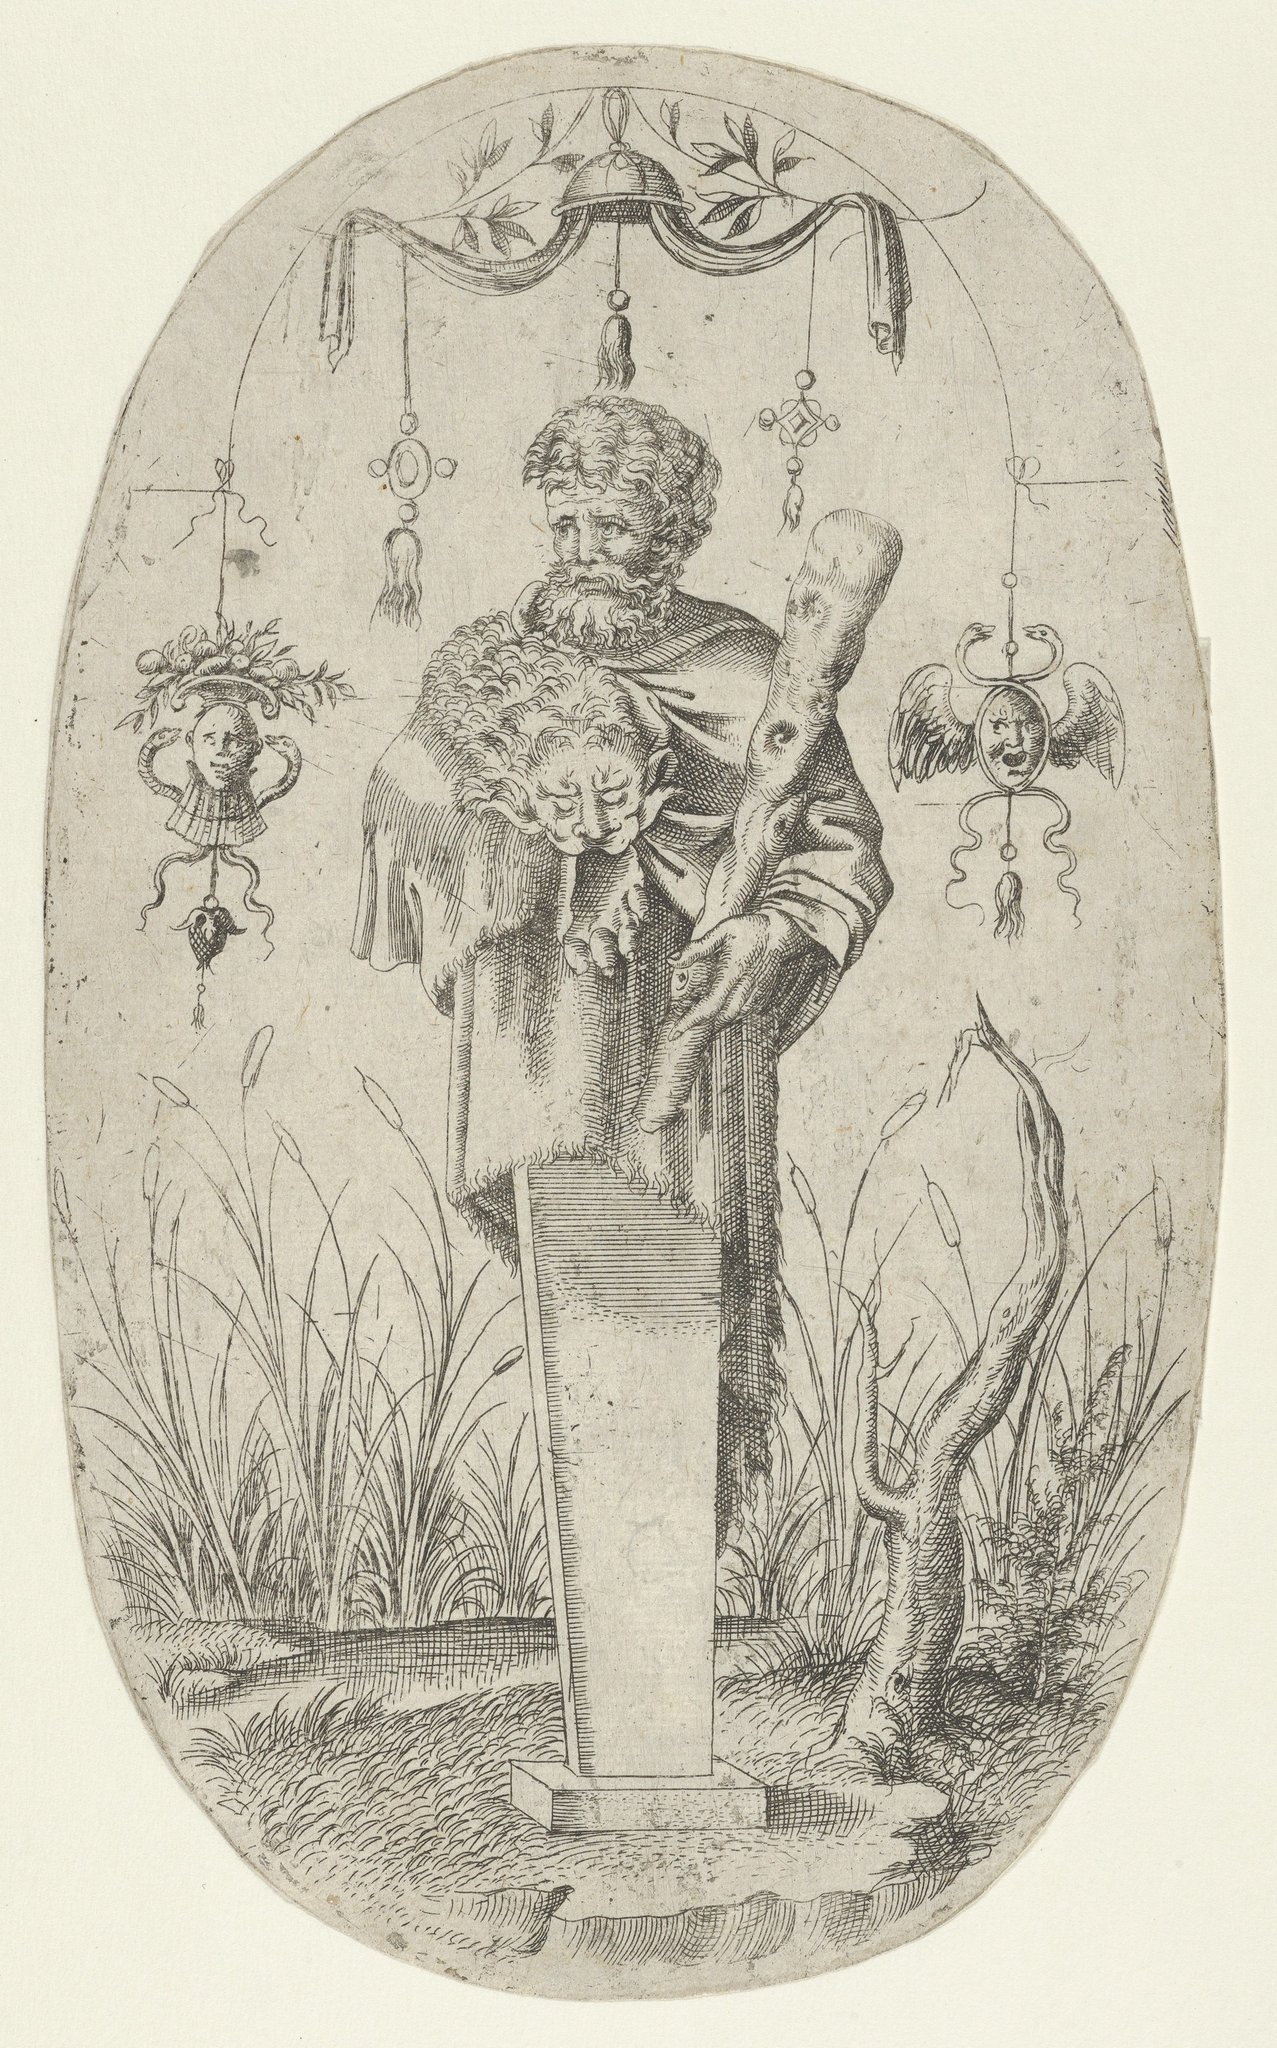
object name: print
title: Term in the form of Hercules With His Club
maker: jean mignon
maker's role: artist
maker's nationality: french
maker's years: 1535-1555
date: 1535-1555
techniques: etching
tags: weapons,hercules